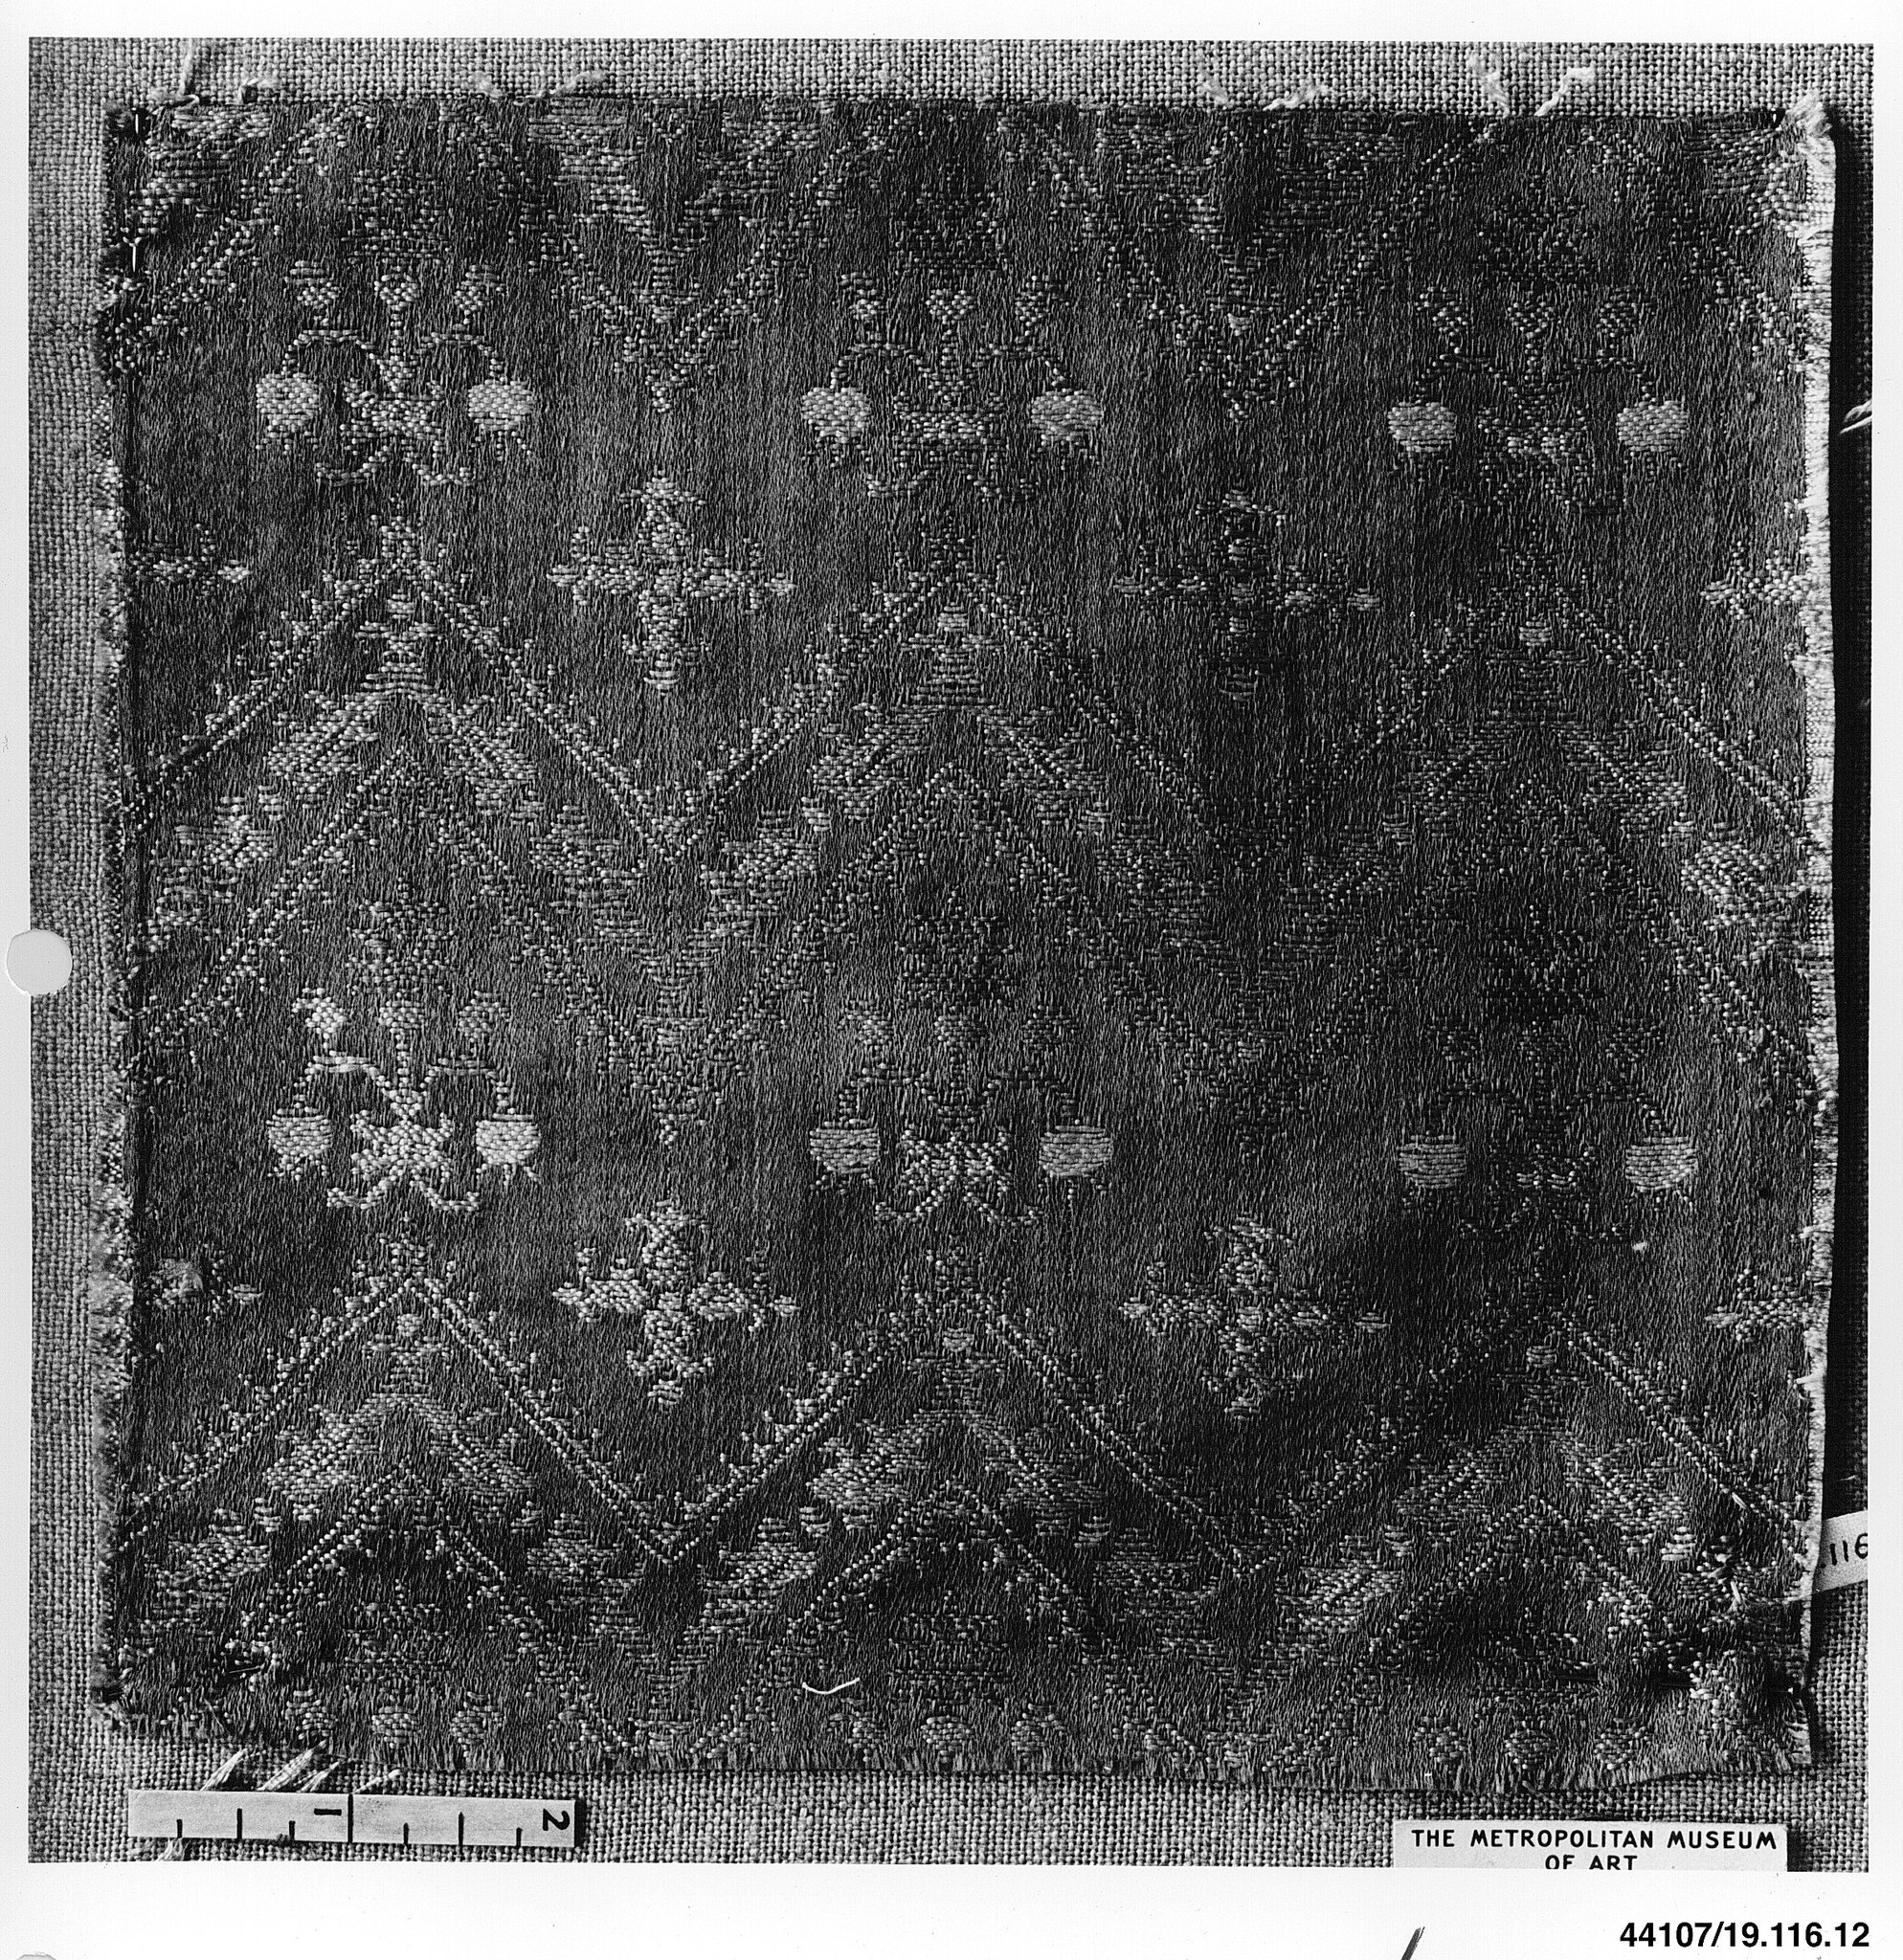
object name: piece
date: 1601-1700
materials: silk